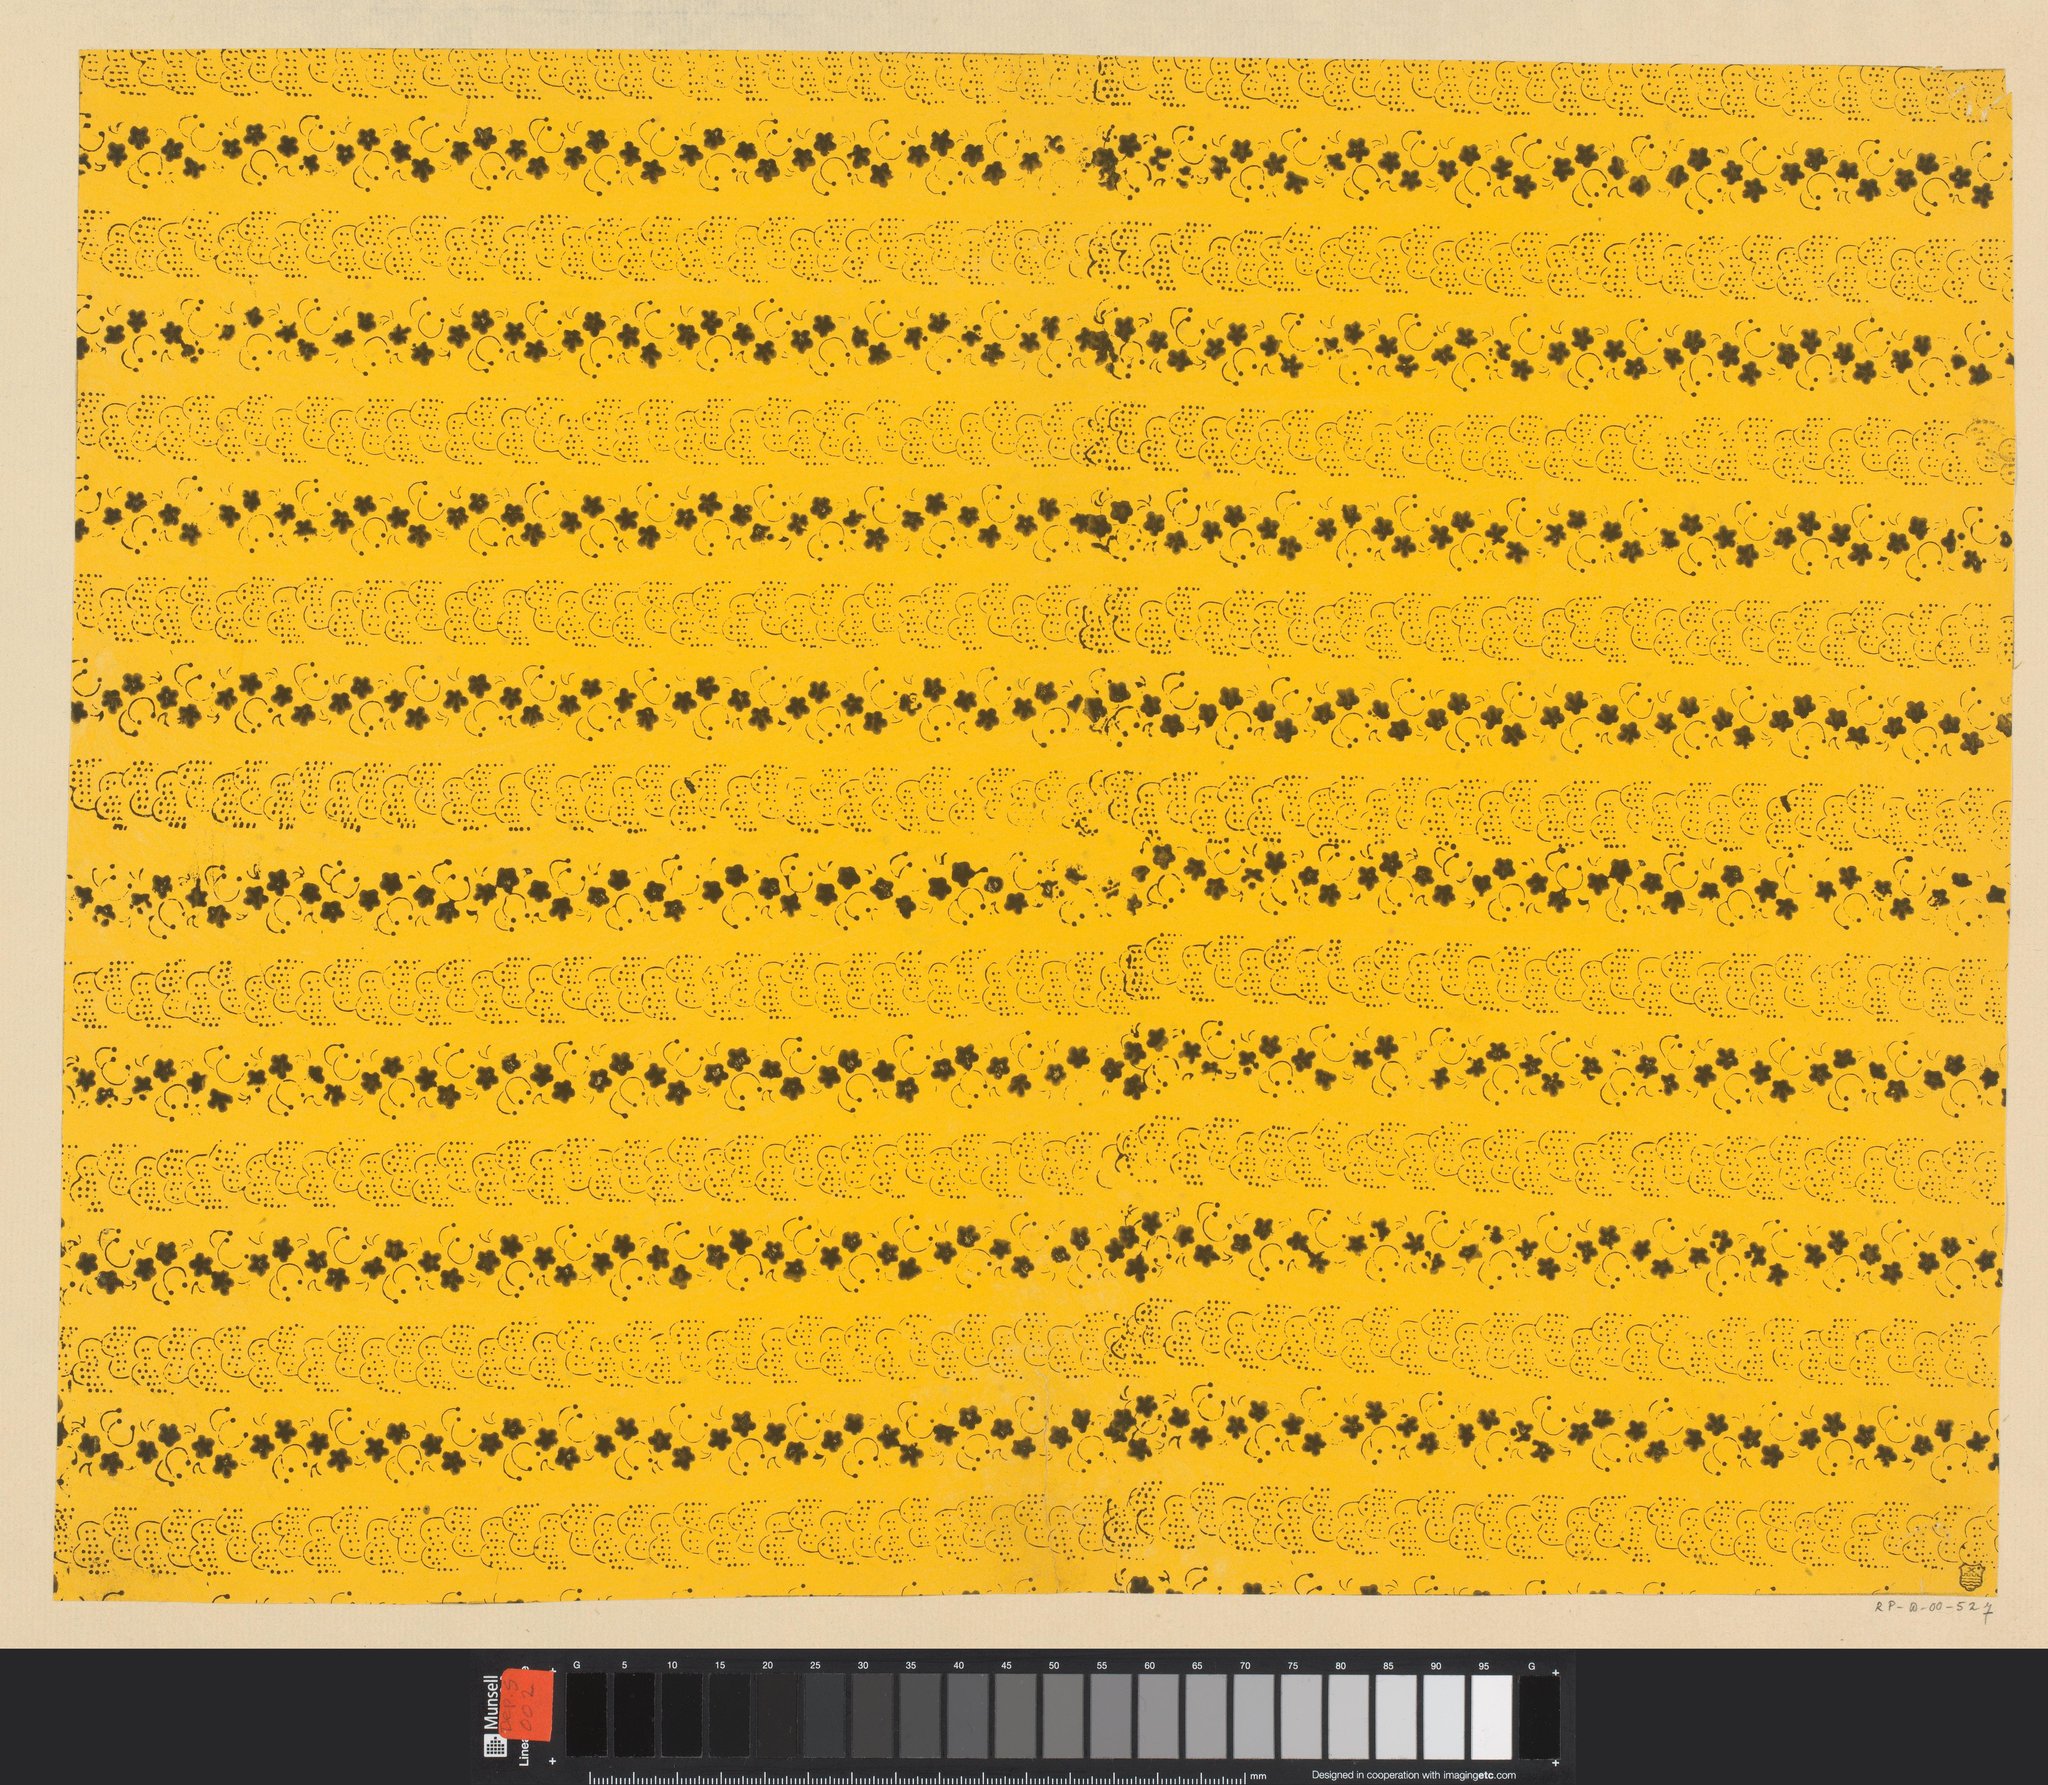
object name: printed paper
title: Blad met banenpatroon van bloemmotief en stippenpatroon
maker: Anonymous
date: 1800-1900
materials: paint, paper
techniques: printing block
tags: ornament derived from plant forms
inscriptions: collector's mark: Lugt 2760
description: Blad met horizontaal banenpatroon van bloemmotief en stippenpatroon.